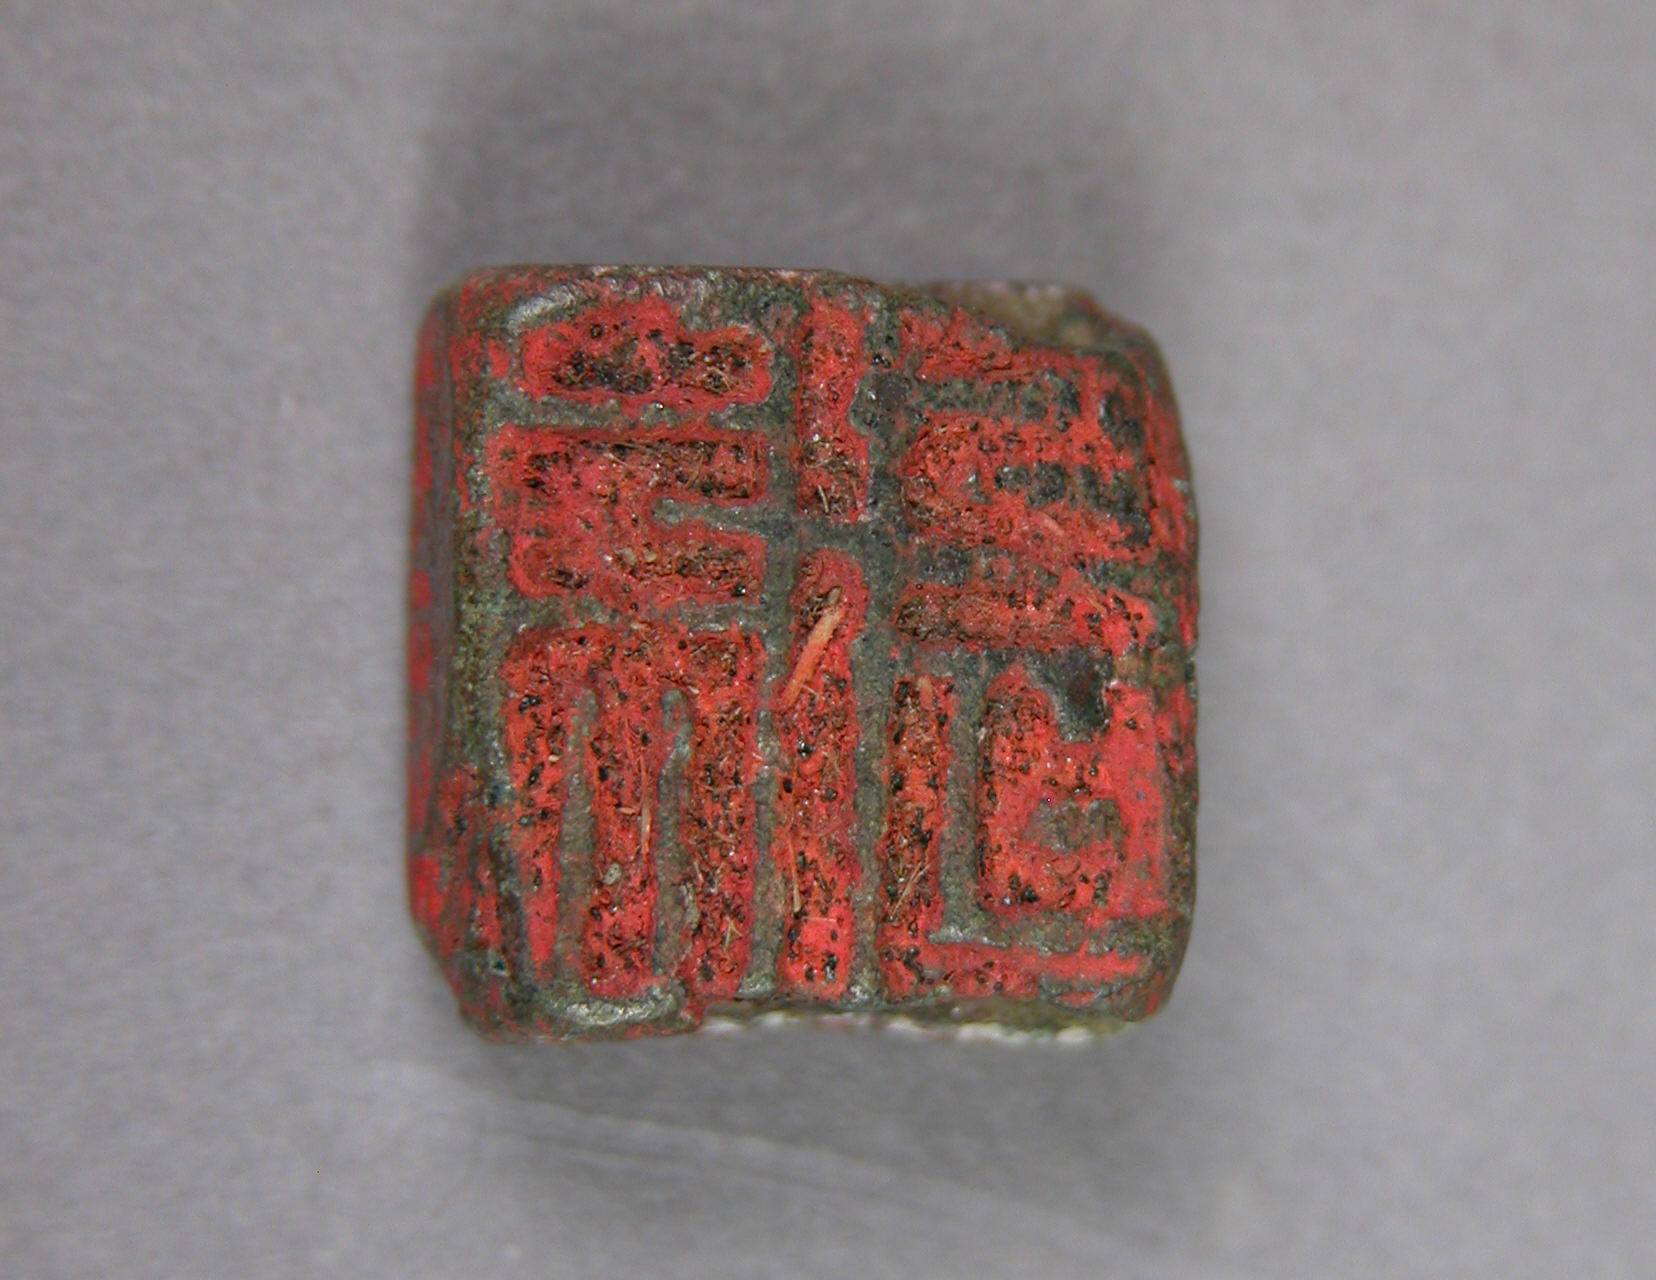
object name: seal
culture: chinese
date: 1300-1644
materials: bronze